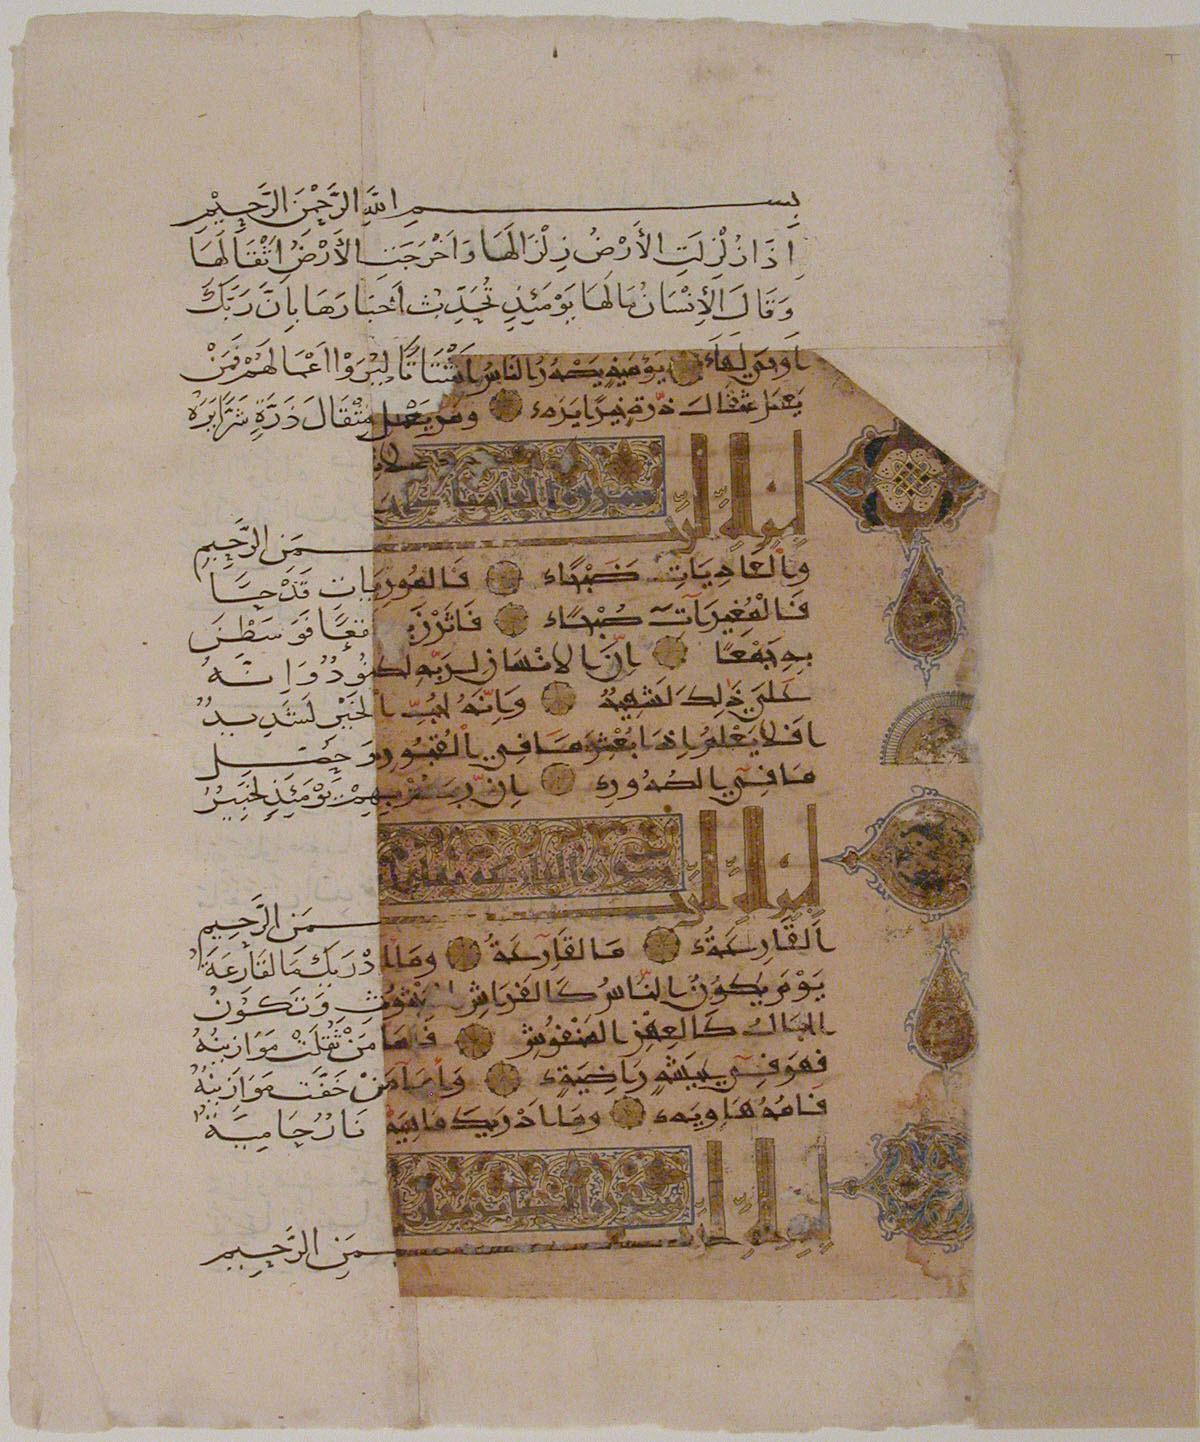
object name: folio from a non illustrated manuscript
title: Folio from a Qur'an Manuscript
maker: muhammad al-zanjani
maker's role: calligrapher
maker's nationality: iranian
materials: gold, ink, paper, watercolor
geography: iran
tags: qur'an,calligraphy